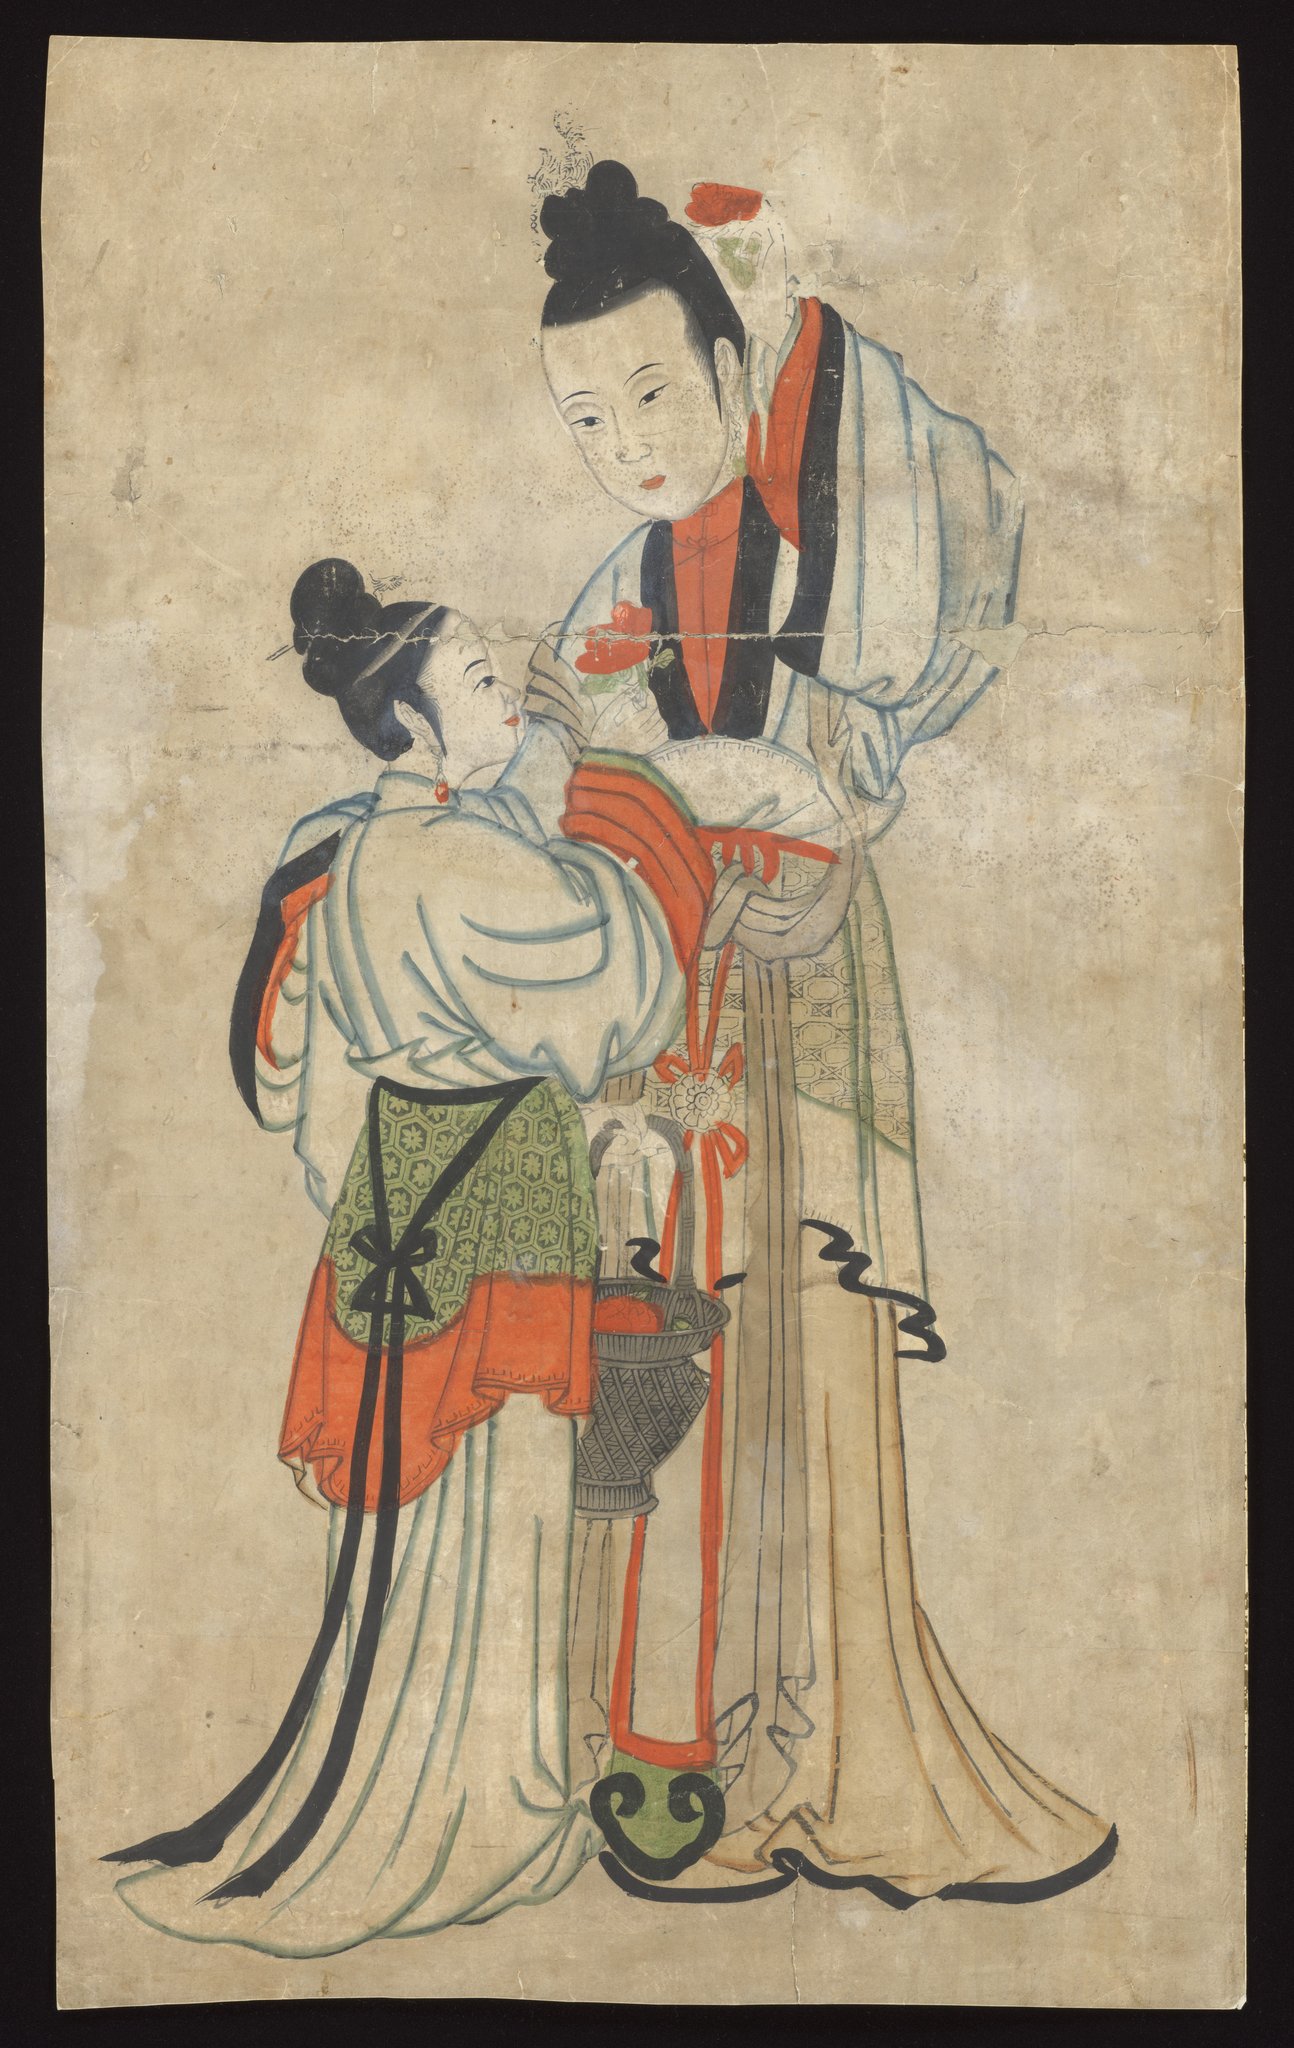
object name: print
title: Ladies with Peony Flowers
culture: chinese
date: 1736-1795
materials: ink, paper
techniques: hand coloring, woodblock print